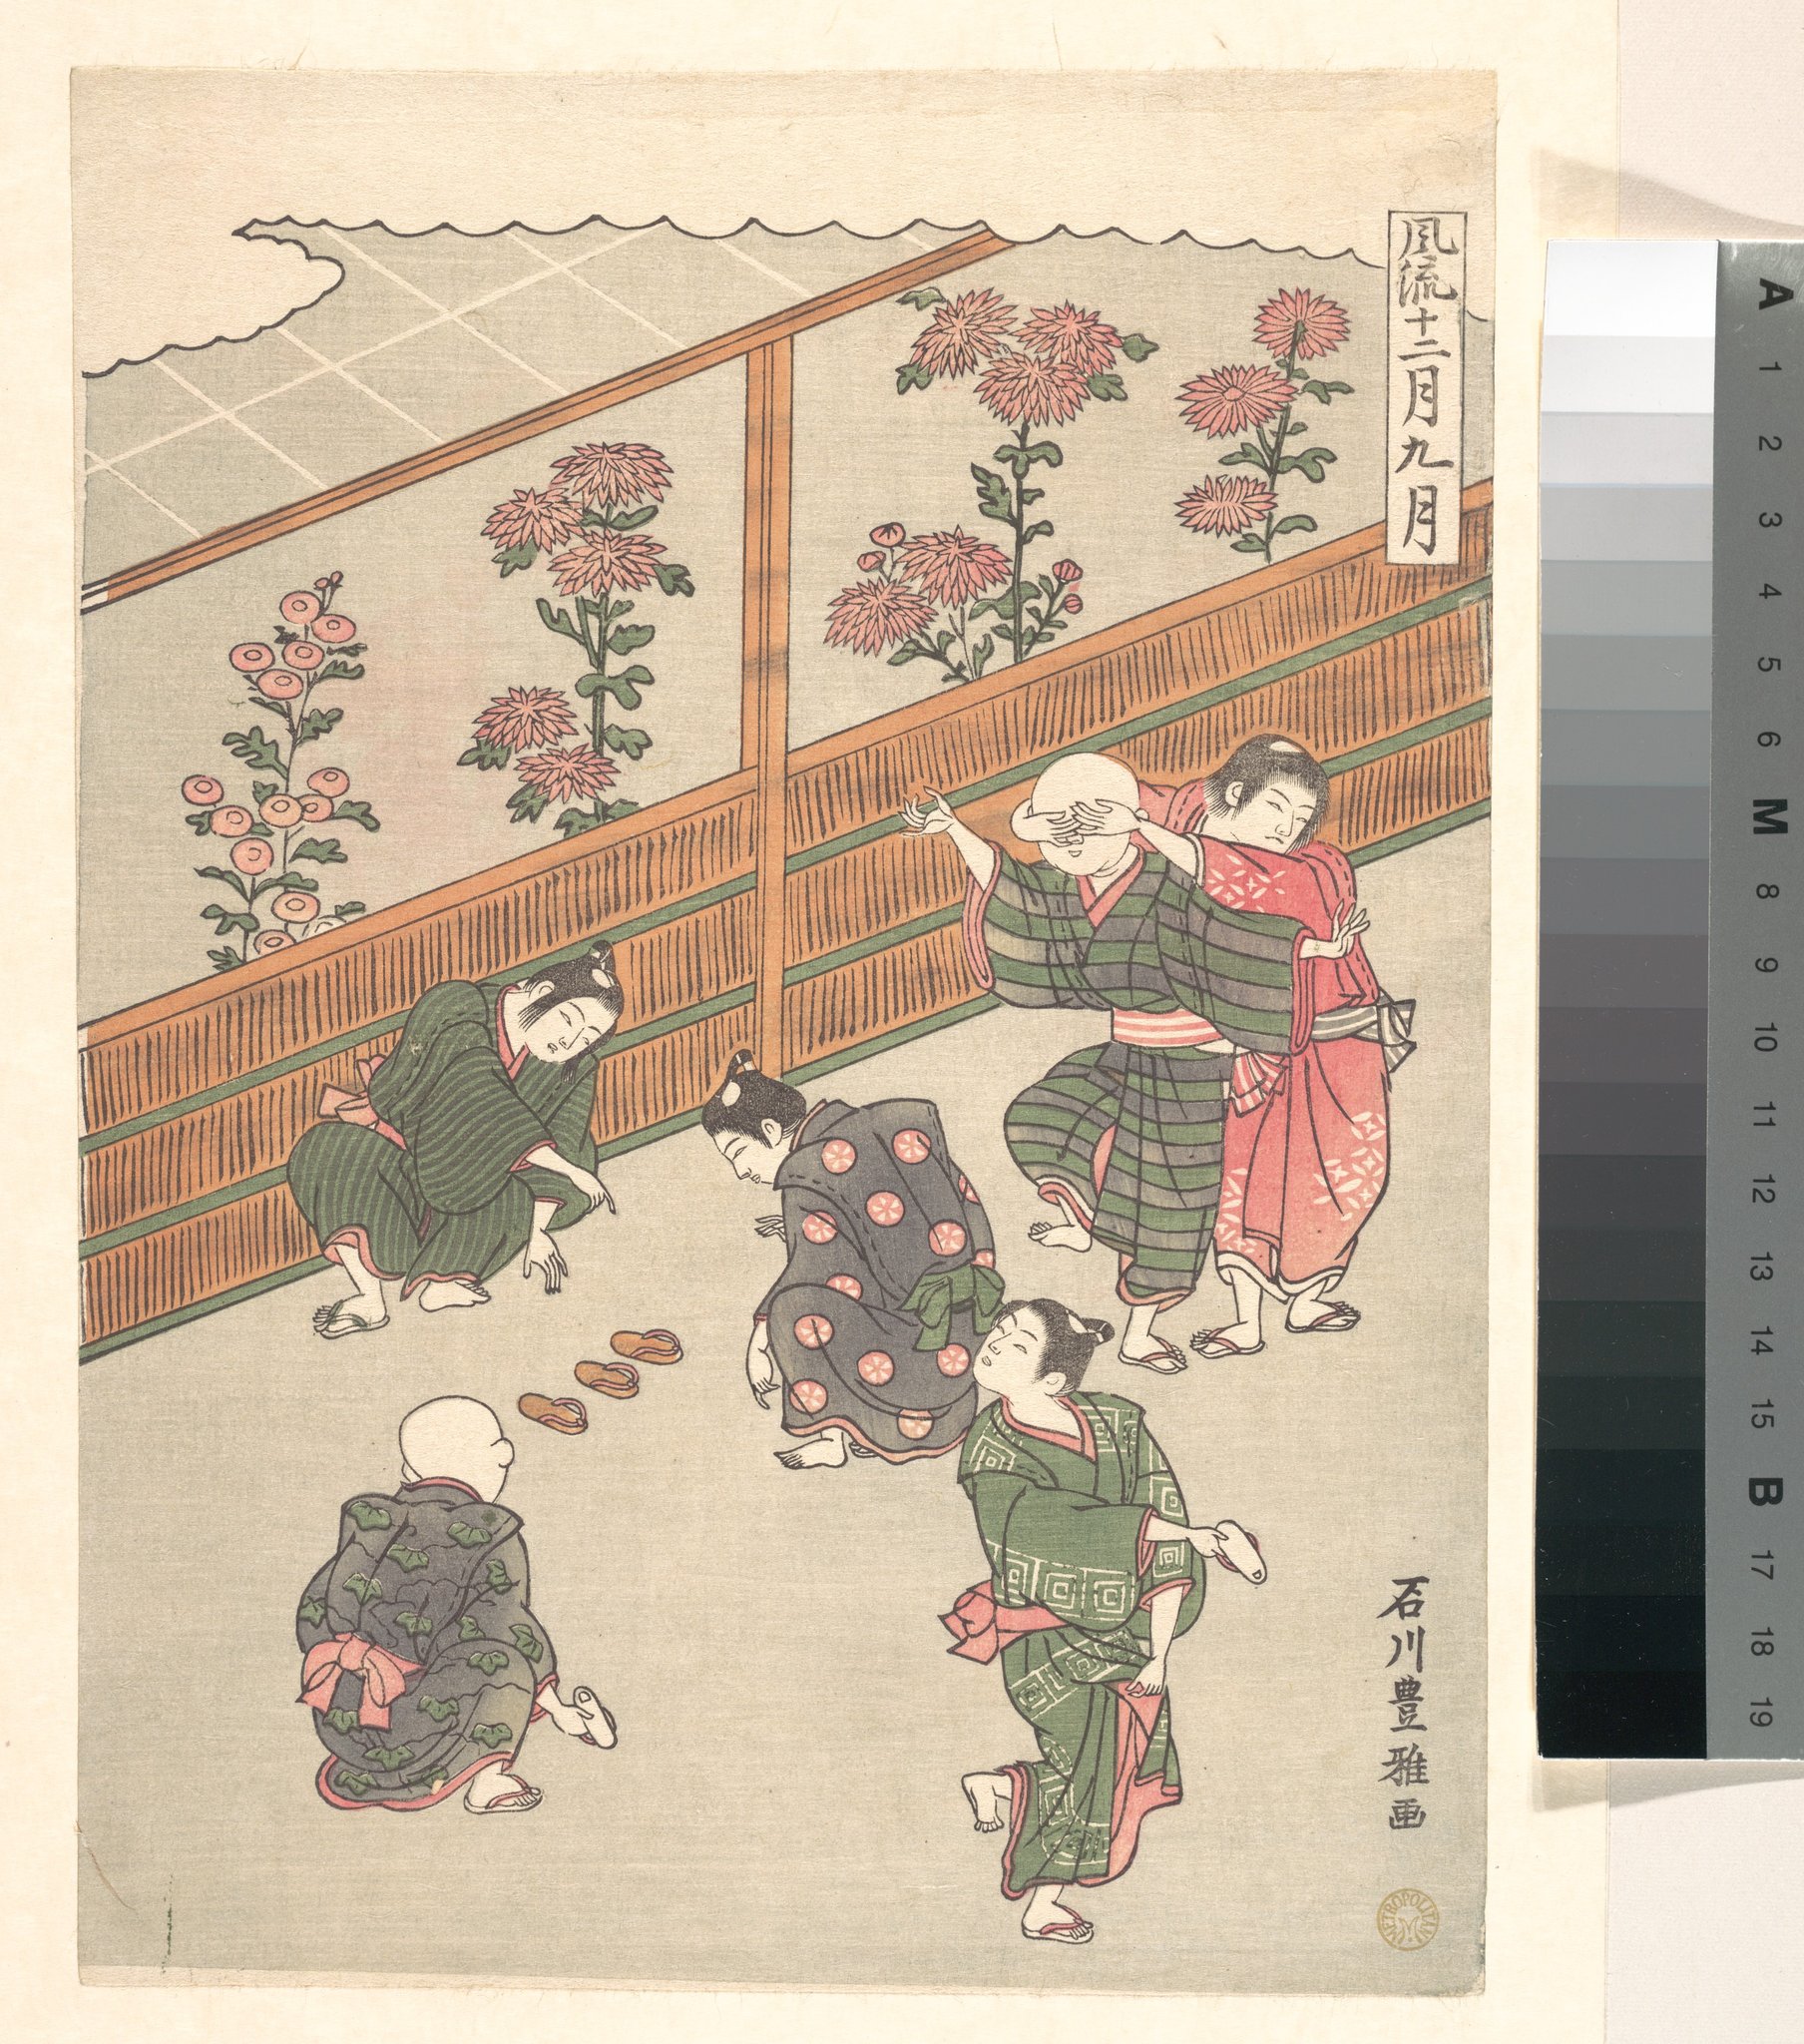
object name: print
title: The Ninth Month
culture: japanese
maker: ishikawa toyomasa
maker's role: artist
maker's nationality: japanese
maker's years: 1770-1790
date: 1767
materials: ink, paper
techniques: woodblock print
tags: footwear,boys,girls,flowers